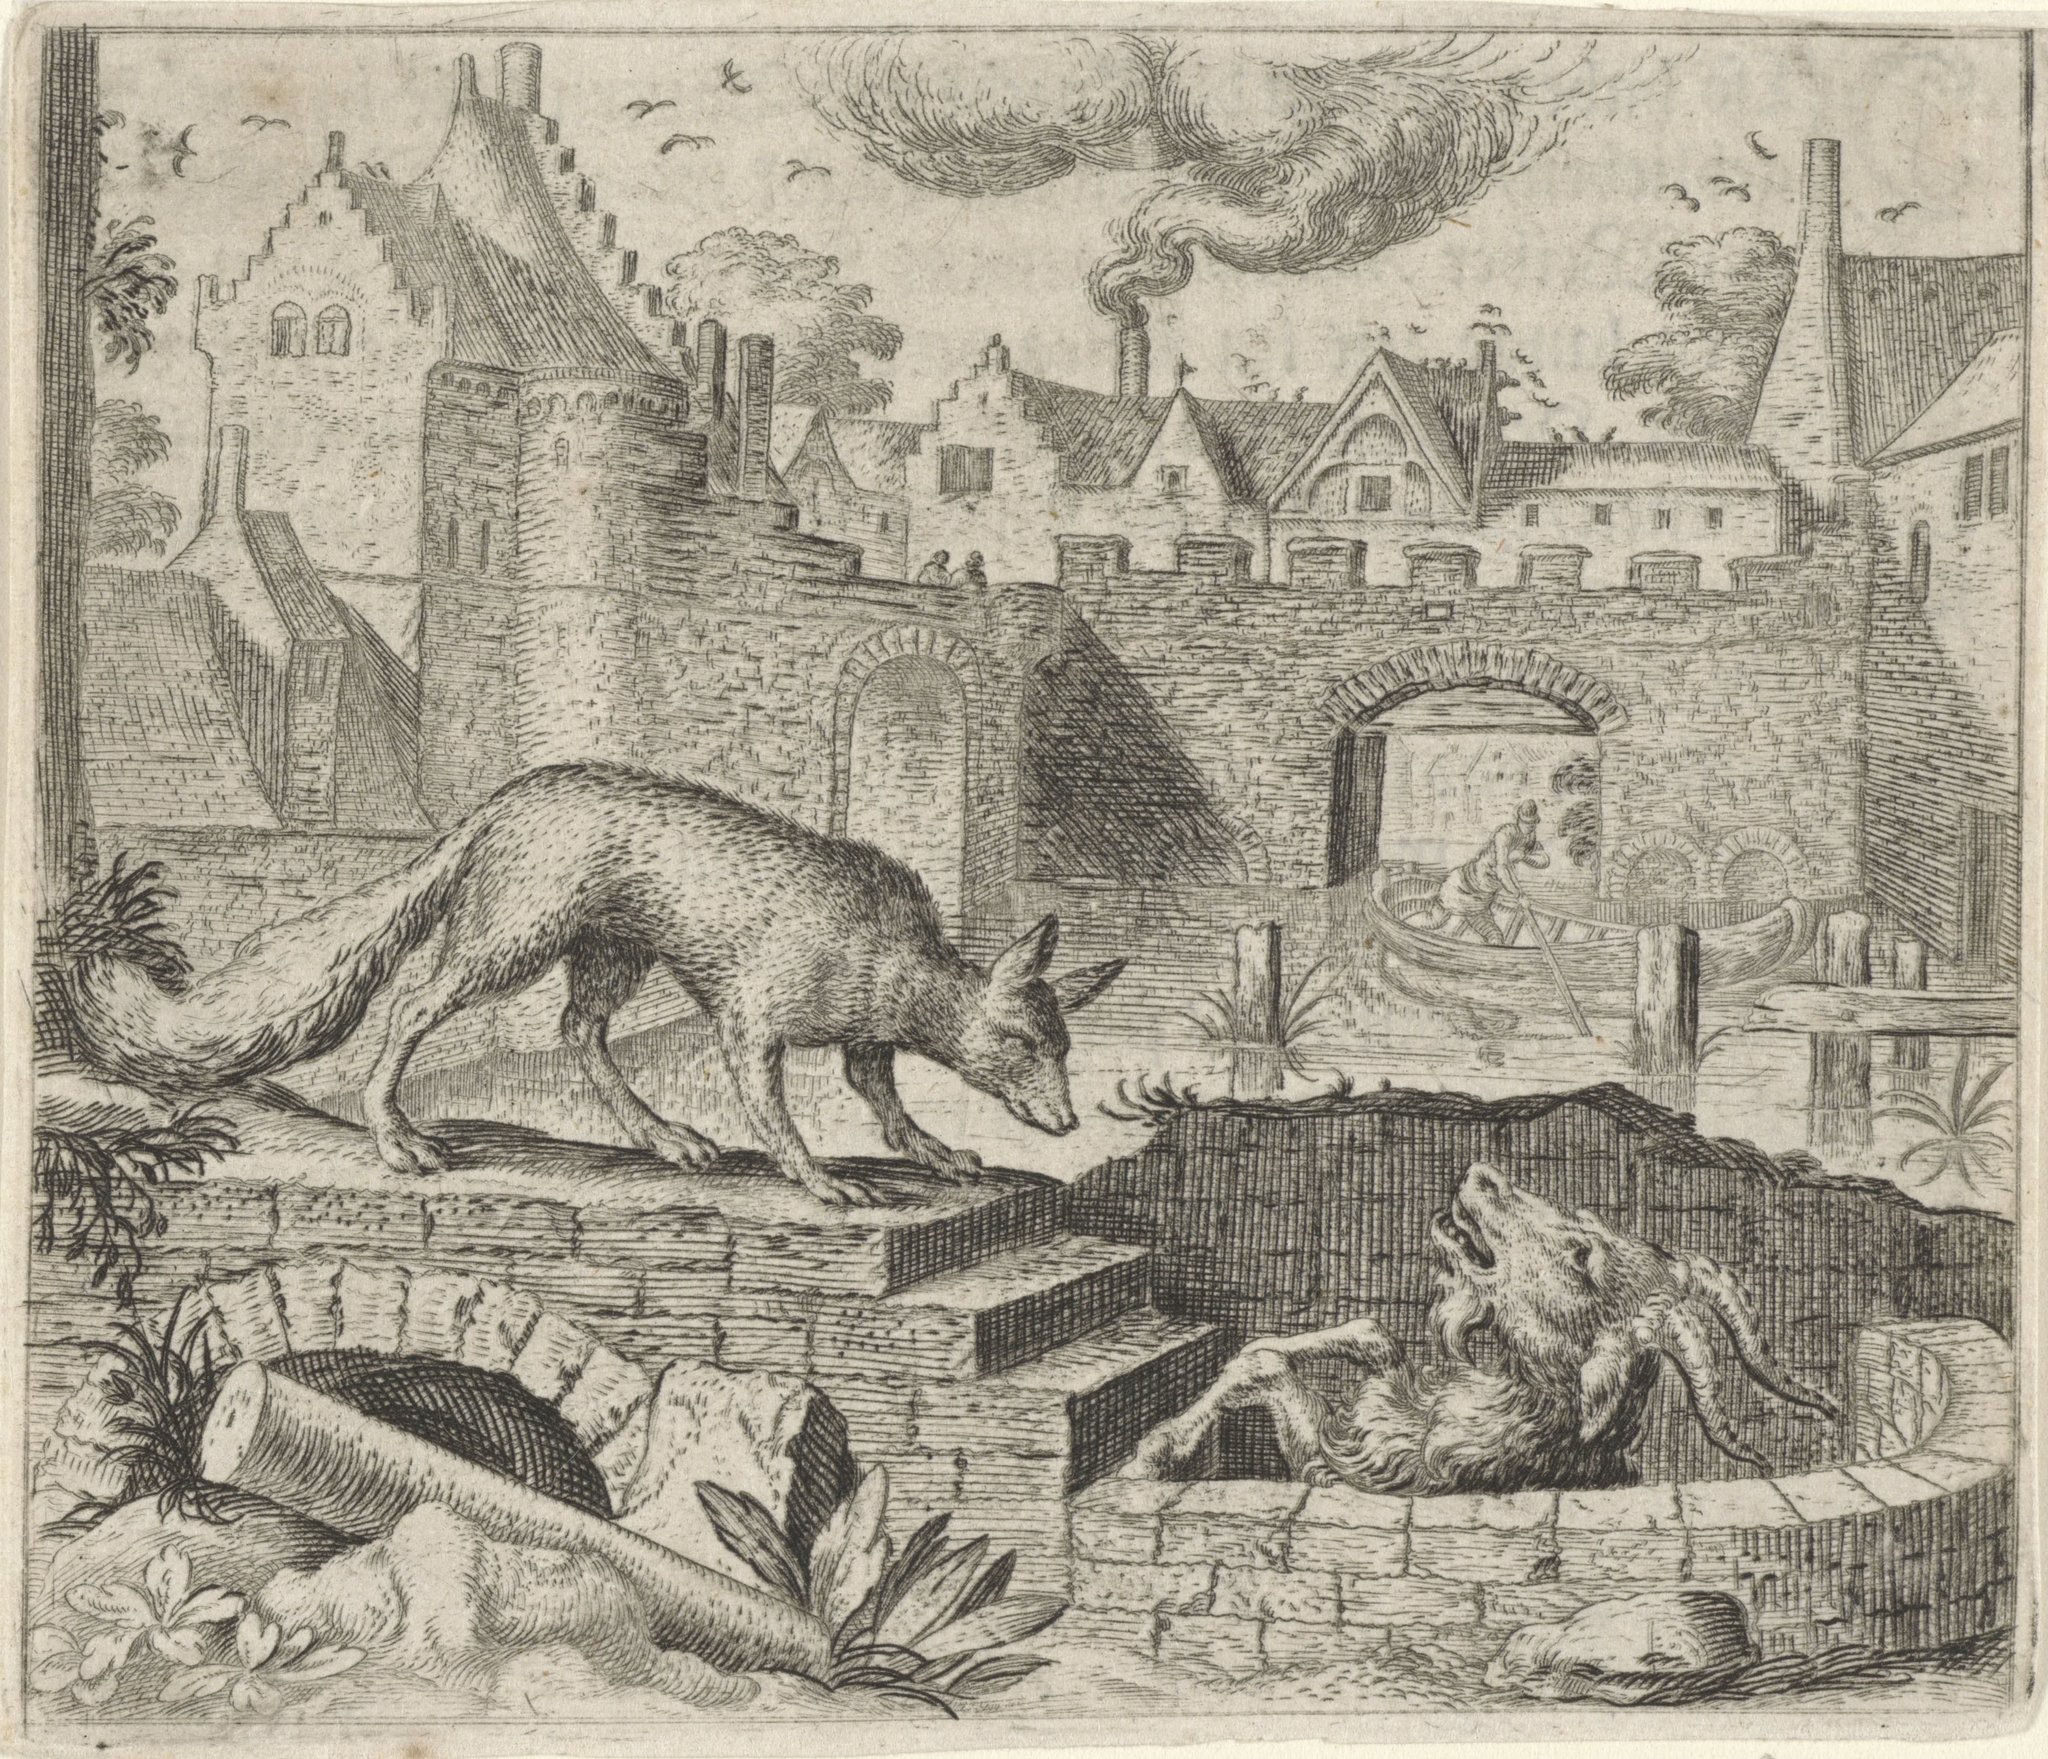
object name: book illustration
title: Fabel van de vos en de geit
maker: aegidius sadeler (ii)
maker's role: draughtsman, print maker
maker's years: 1568-1629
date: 1608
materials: paper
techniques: engraving, etching, letterpress printing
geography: prague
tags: fables, goat, beasts of prey, predatory animals: fox, cellar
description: De vos staat boven een keldertrap. De geit zit in de kelder. Op de achtergrond een stad. De fabel beschrijft hoe de vos samen met een geit een kelder binnenbreken om daar wijn te drinken. De geit helpt de vos de kelder opnieuw te verlaten, maar kan er zonder hulp zelf niet uit. Het verhaal waarschuwt voor edelmoedig handelen.